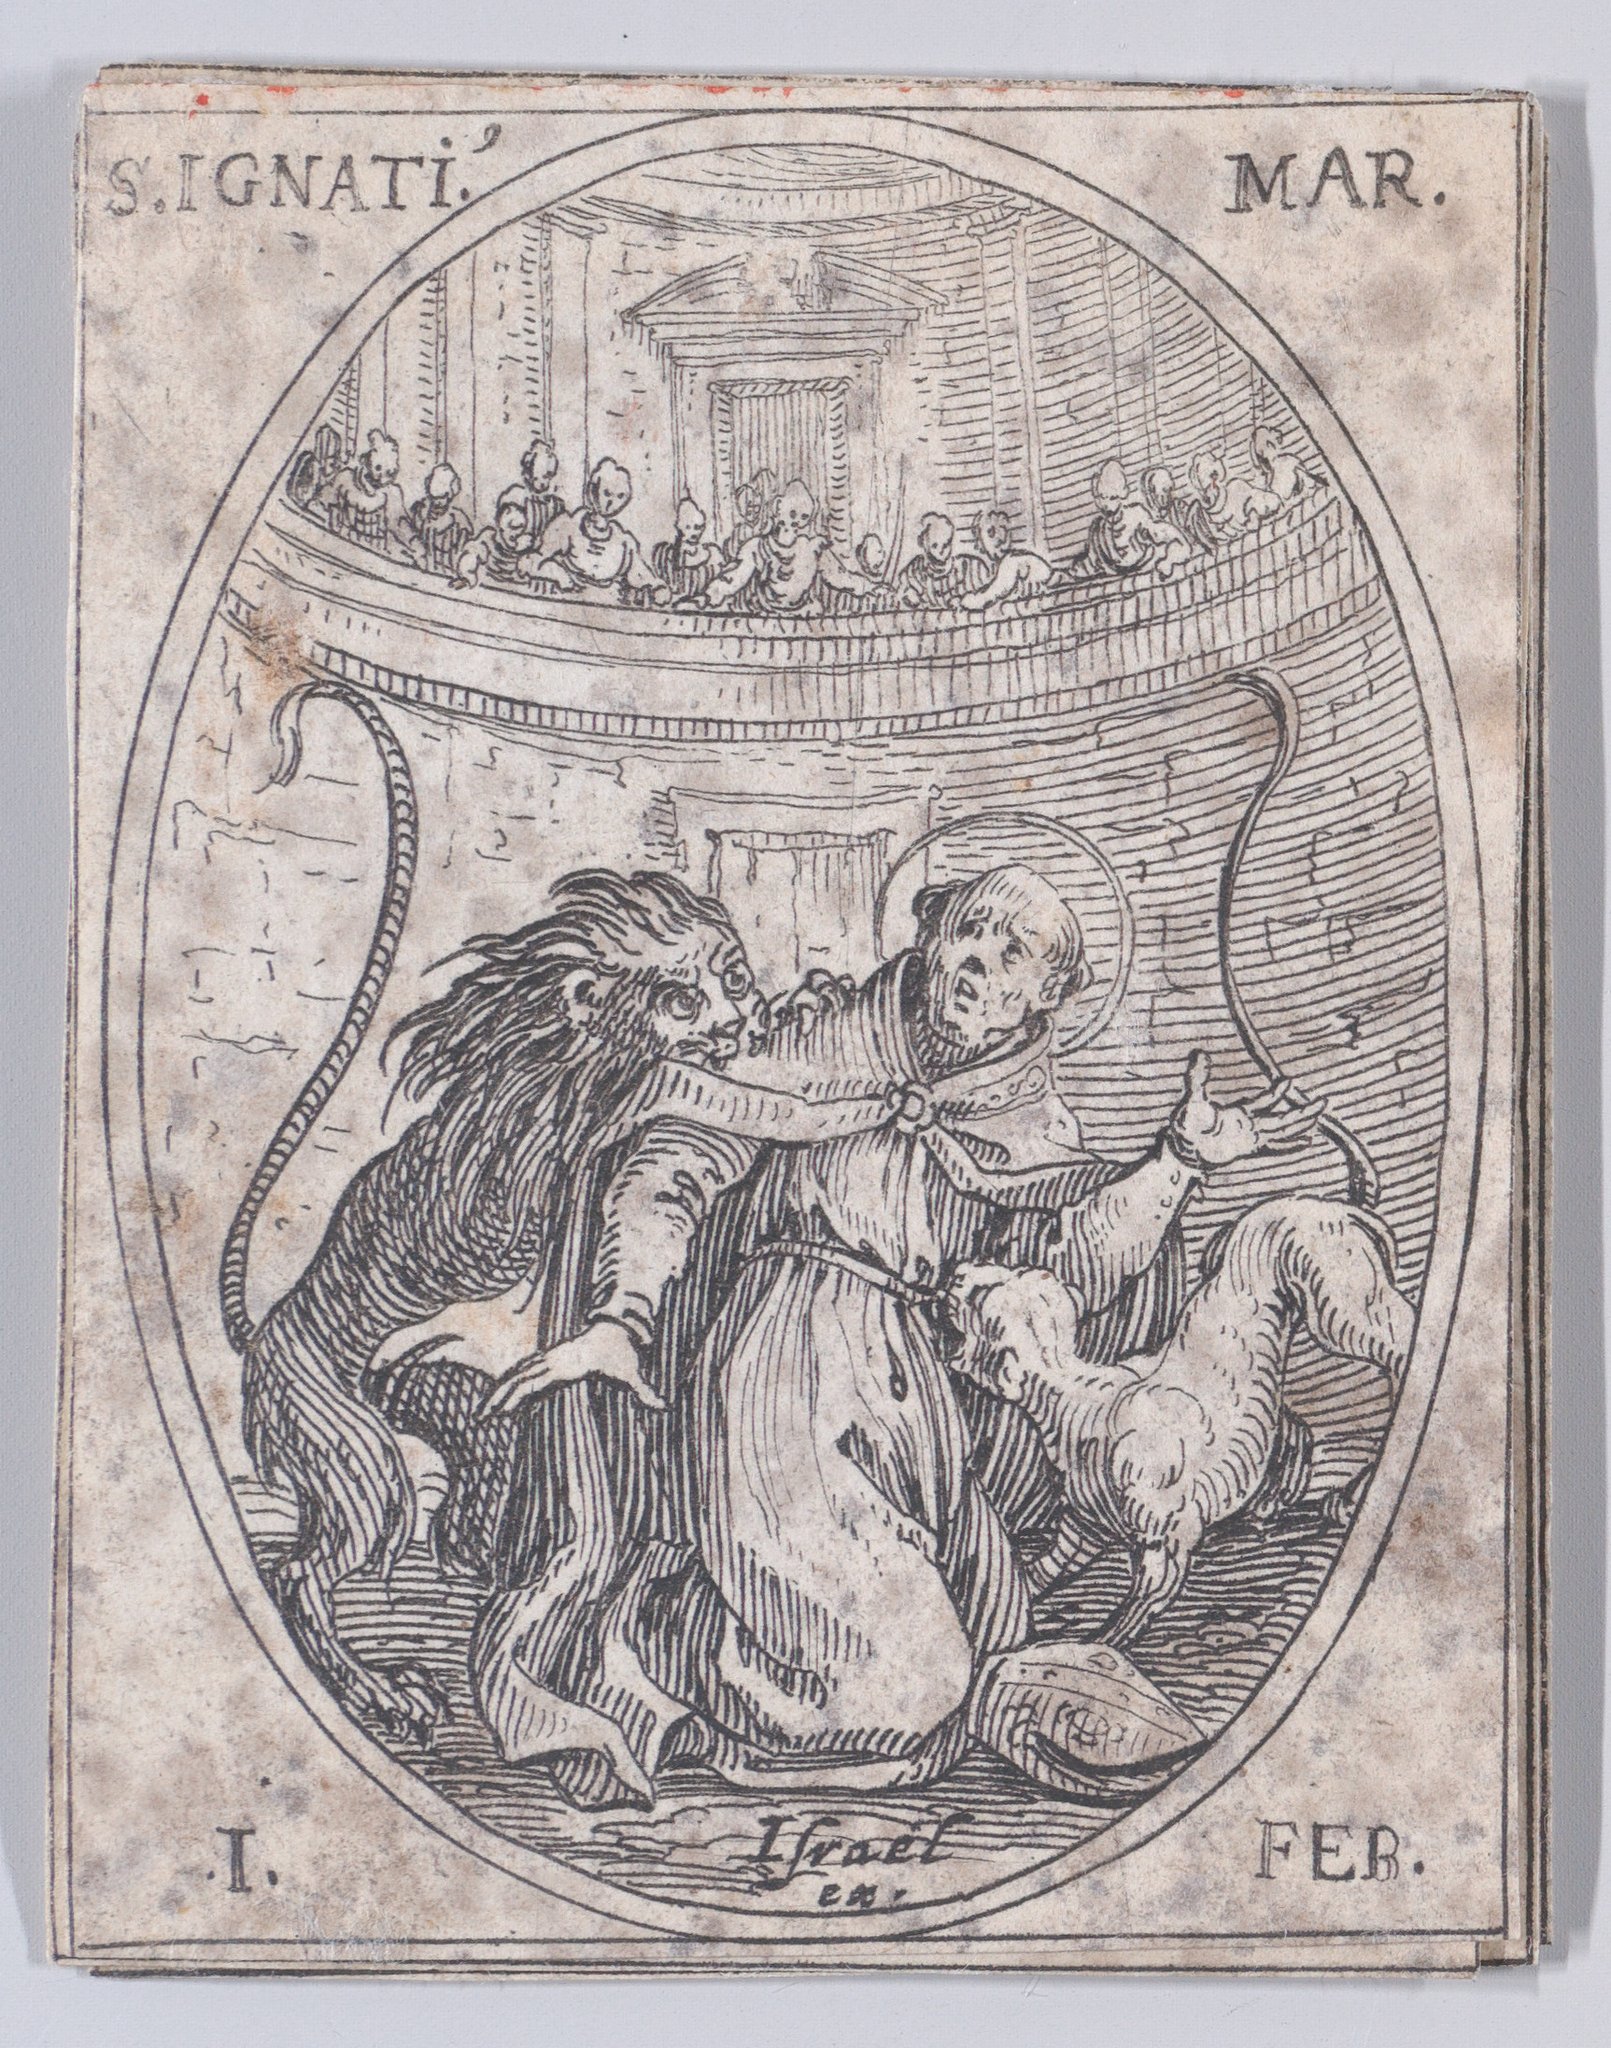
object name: print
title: S. Ignace, martyr (St. Ignatius, Martyr), February 1st, from "Les Images De Tous Les Saincts et Saintes de L'Année" (Images of All of the Saints and Feast Days of the Year)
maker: jacques callot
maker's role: artist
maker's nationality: french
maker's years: 1592-1635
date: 1636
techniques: etching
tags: men,dogs,lions,saints